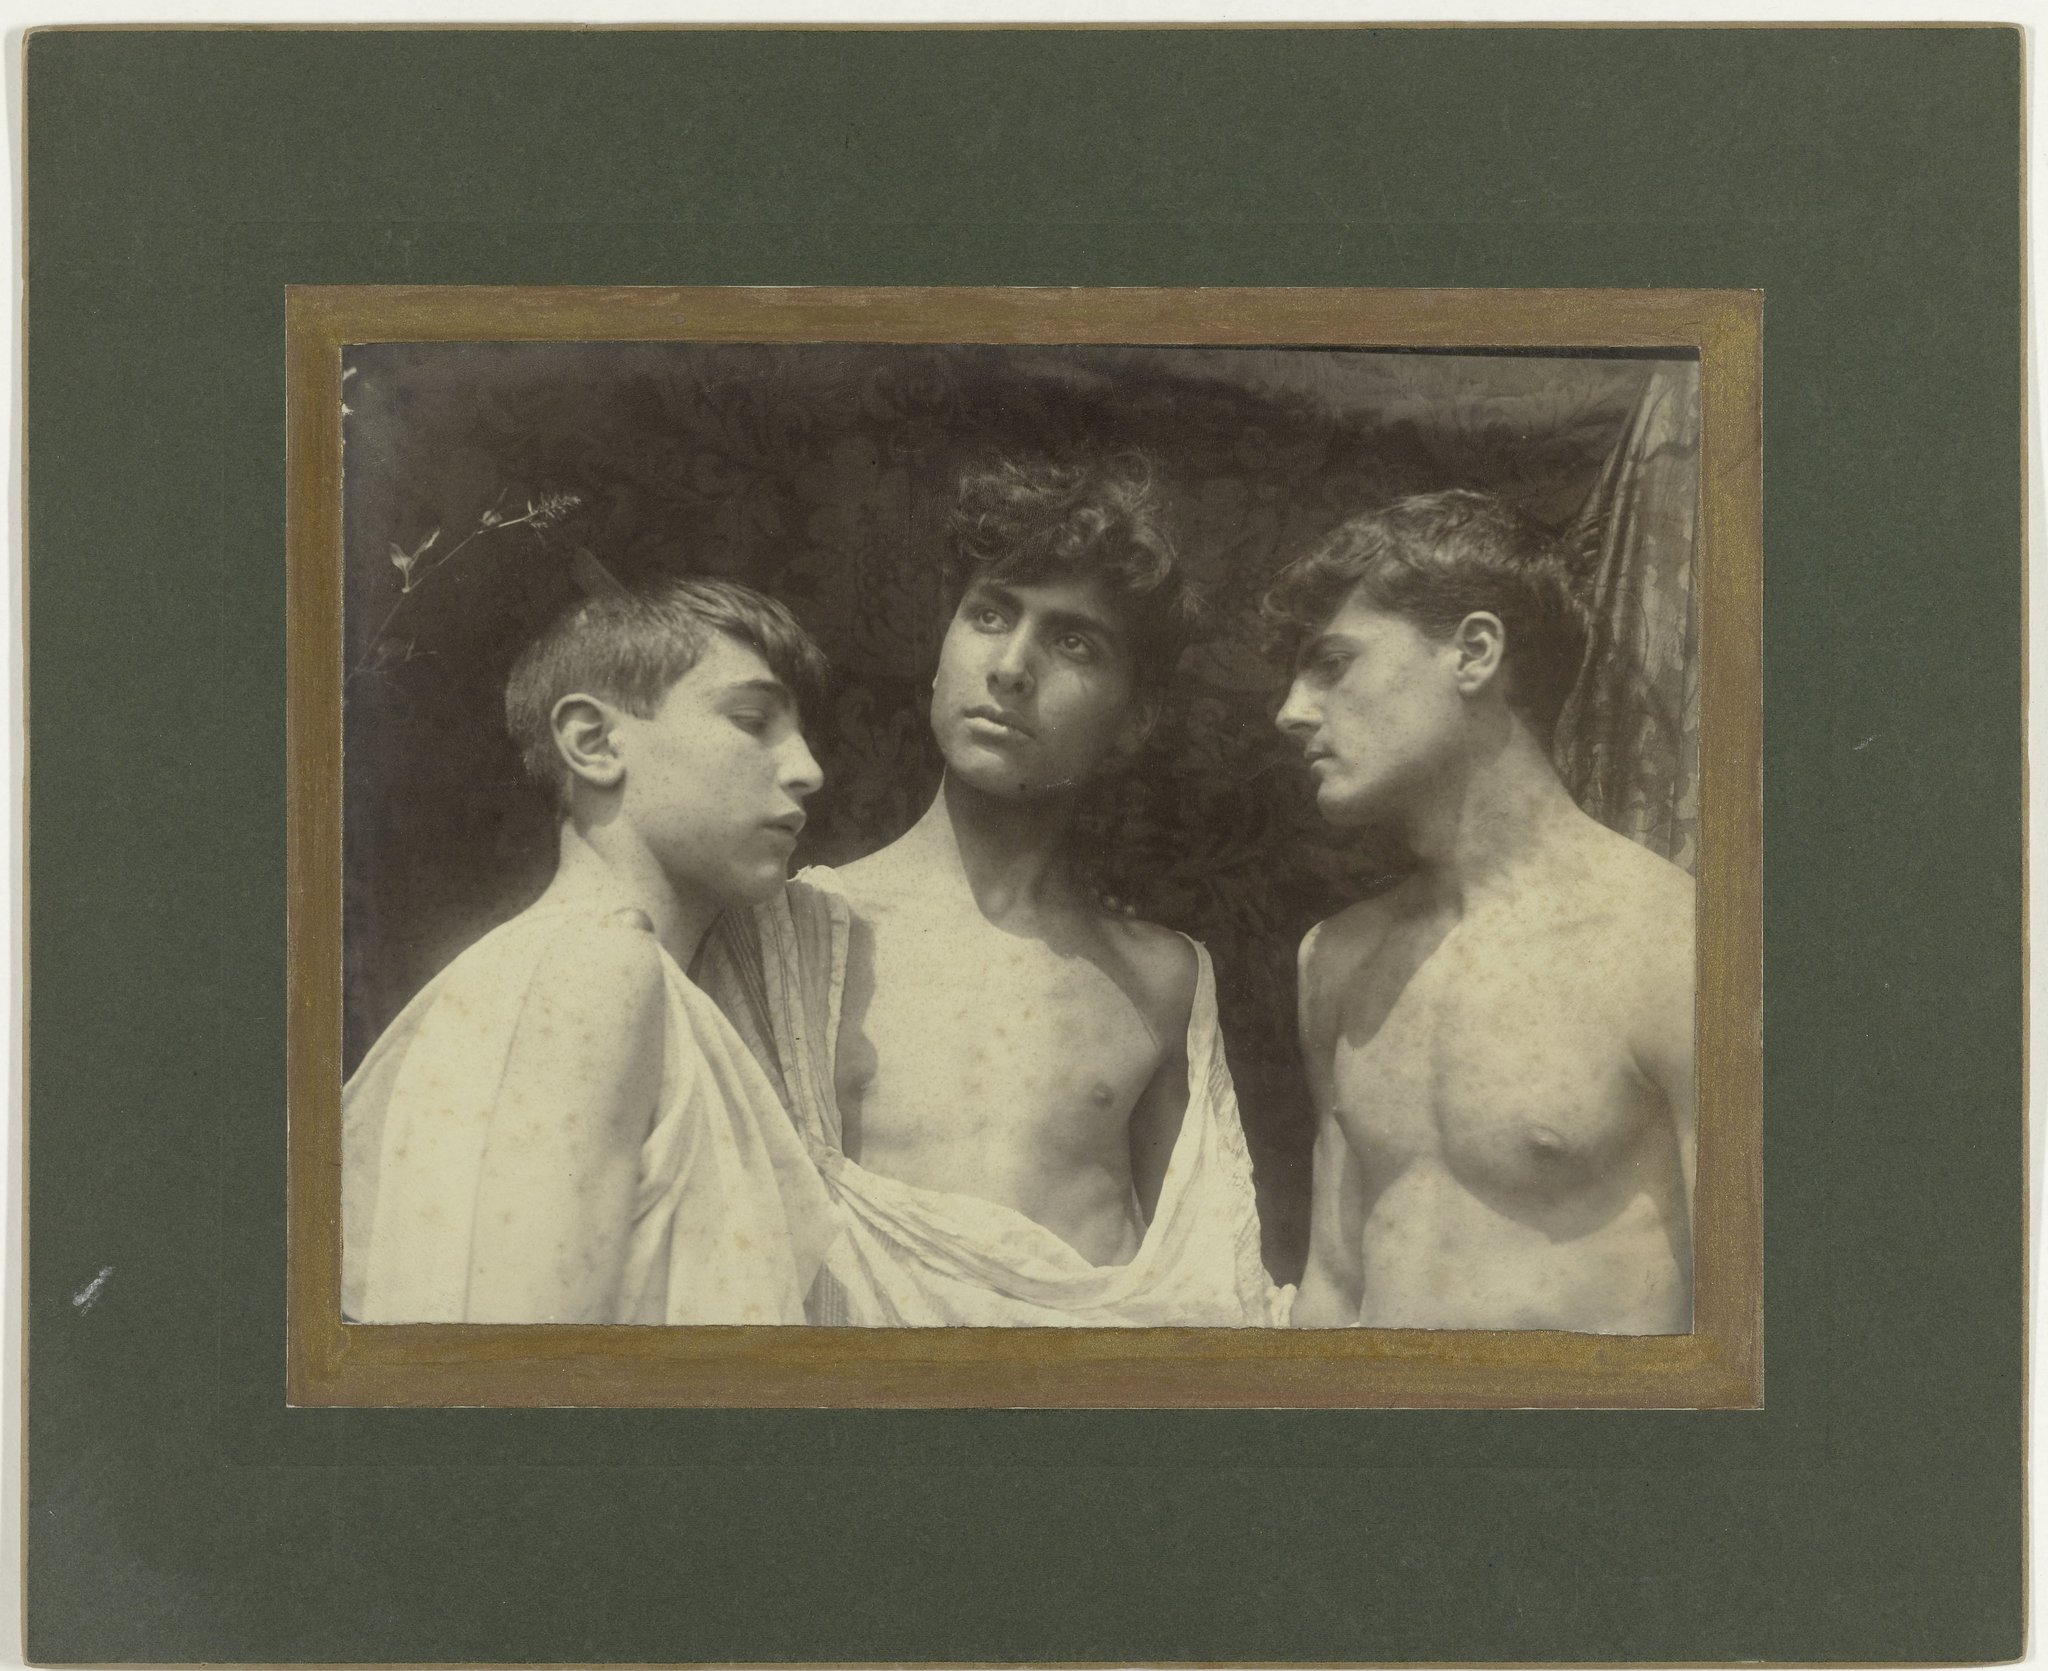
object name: photograph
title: Drie jongens met toga's en ontblote bovenlichamen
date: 1900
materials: cardboard, paper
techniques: albumen print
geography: taormina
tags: youth, adolescent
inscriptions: inscription: ‘foto baron Wilhelm von Gloeden/ geb Mecklenburg 1856 overleden Taormina 1931/ gemaakt Taormina, Sicilië ± 1900’